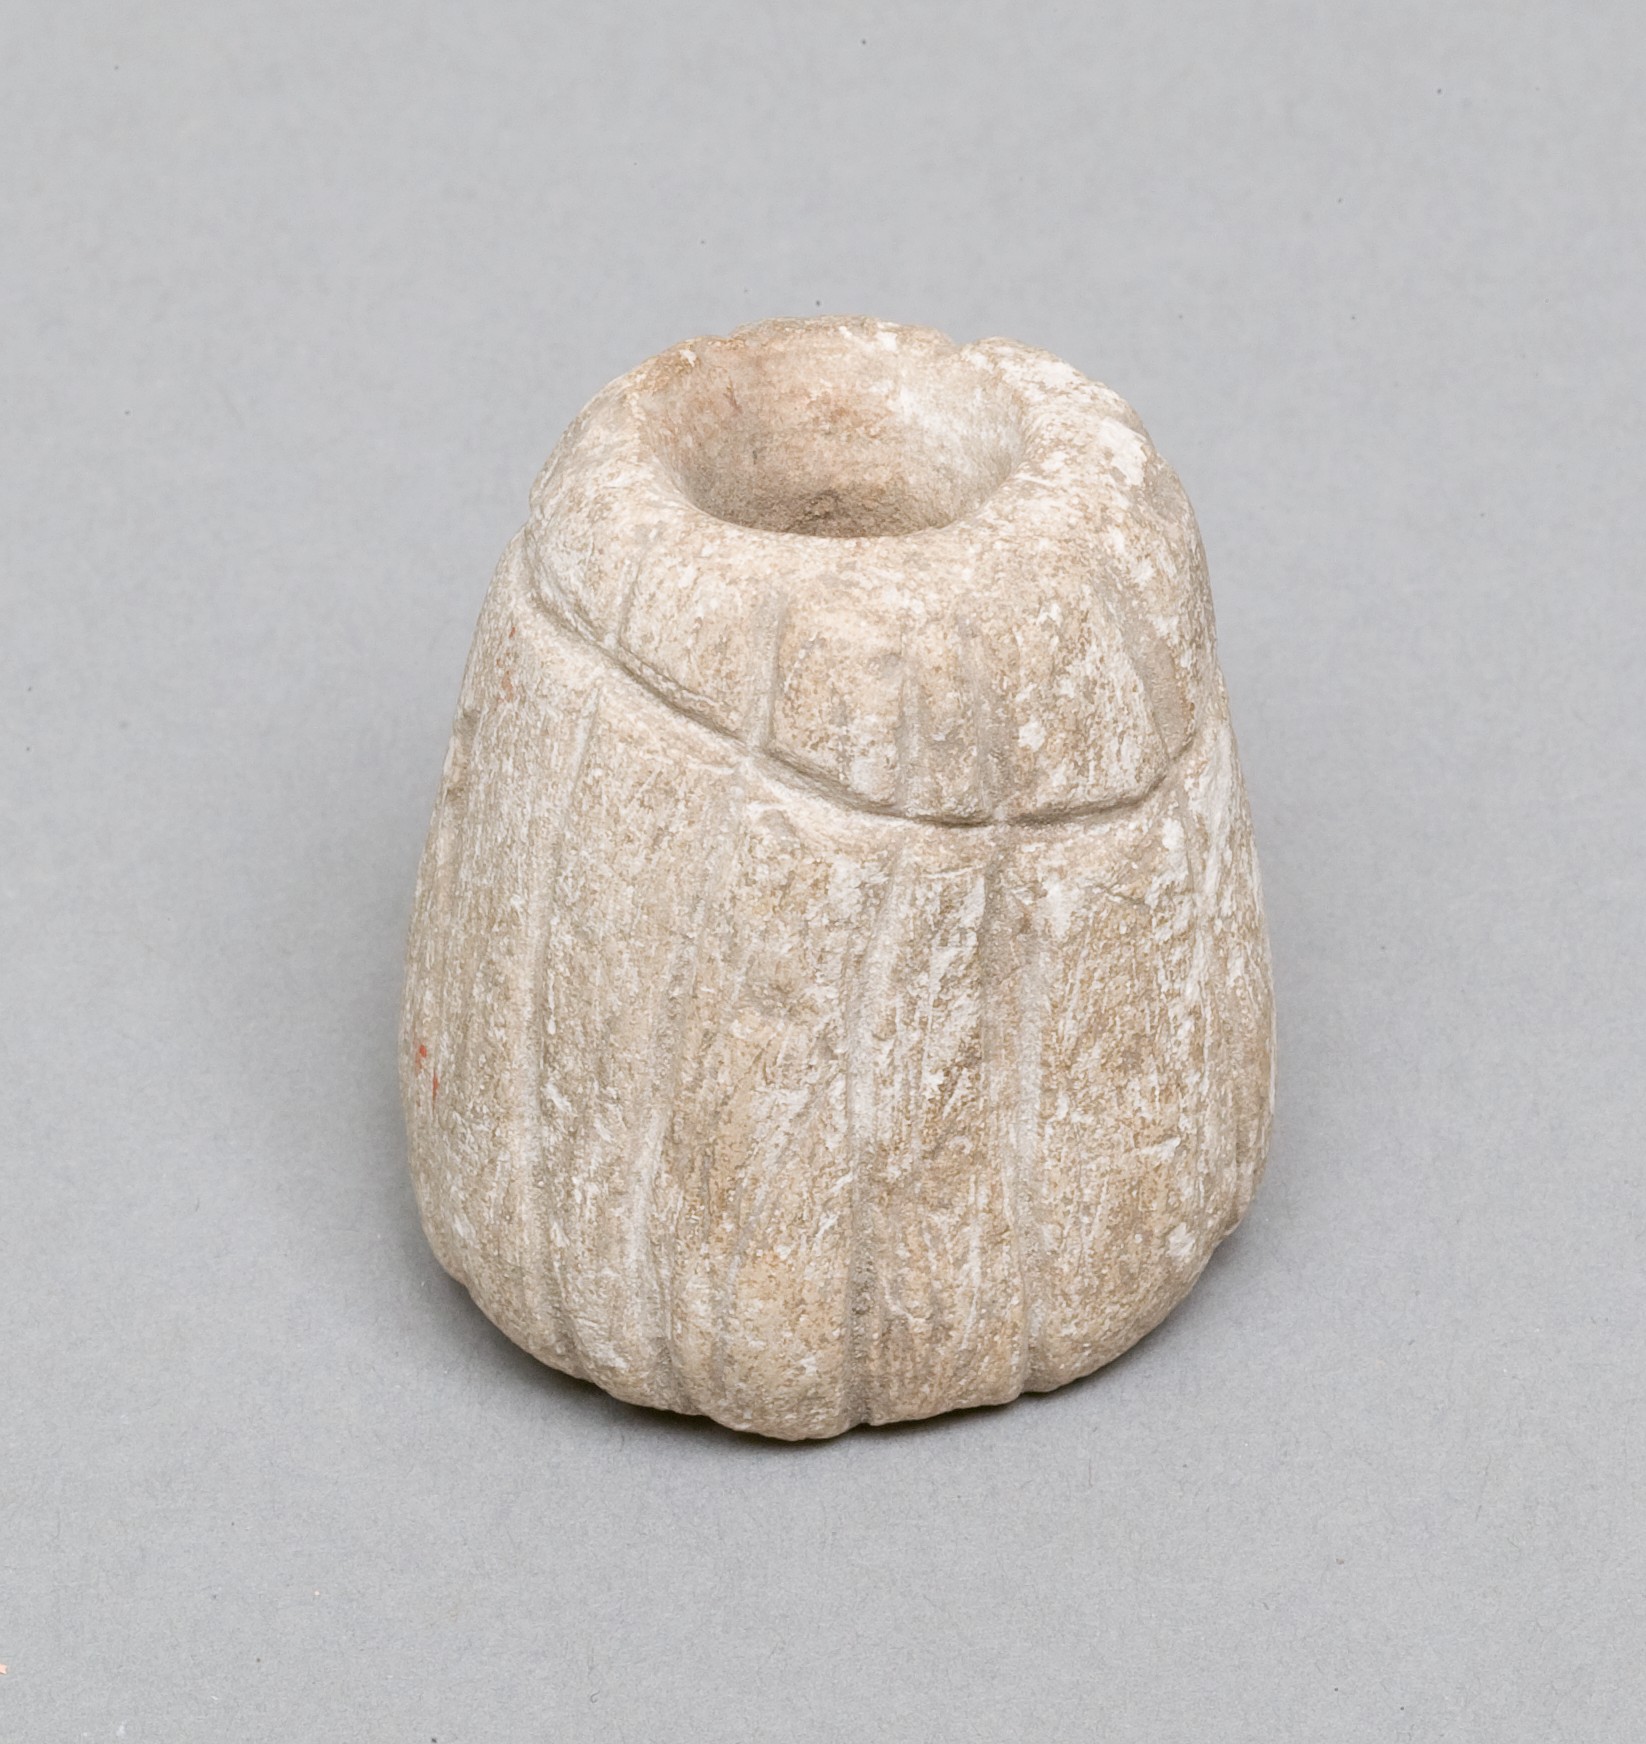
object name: spindle whorl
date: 1295-1070 BCE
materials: limestone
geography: egypt